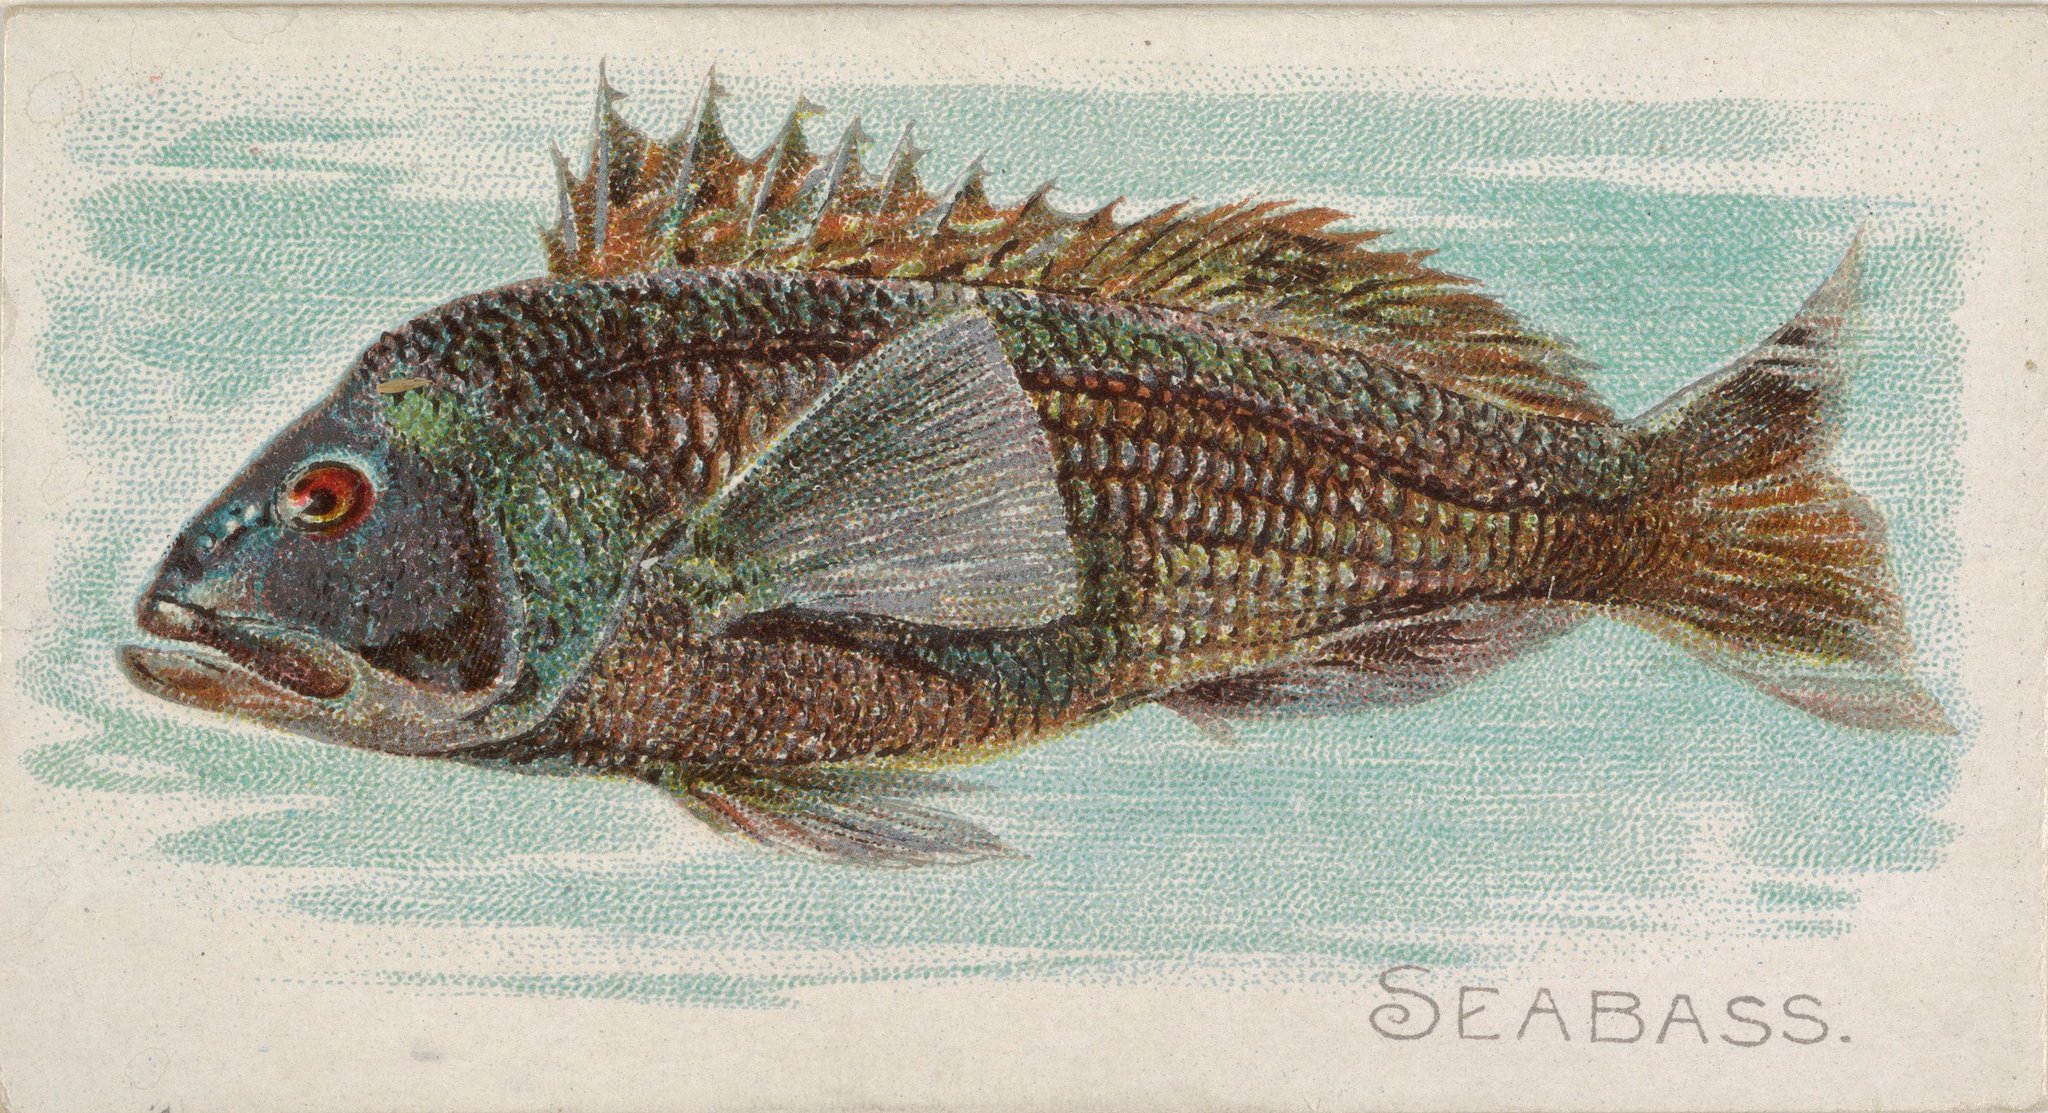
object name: print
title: Sea Bass, from the Fish from American Waters series (N8) for Allen & Ginter Cigarettes Brands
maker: allen & ginter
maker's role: publisher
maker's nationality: american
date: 1889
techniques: color lithograph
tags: fish